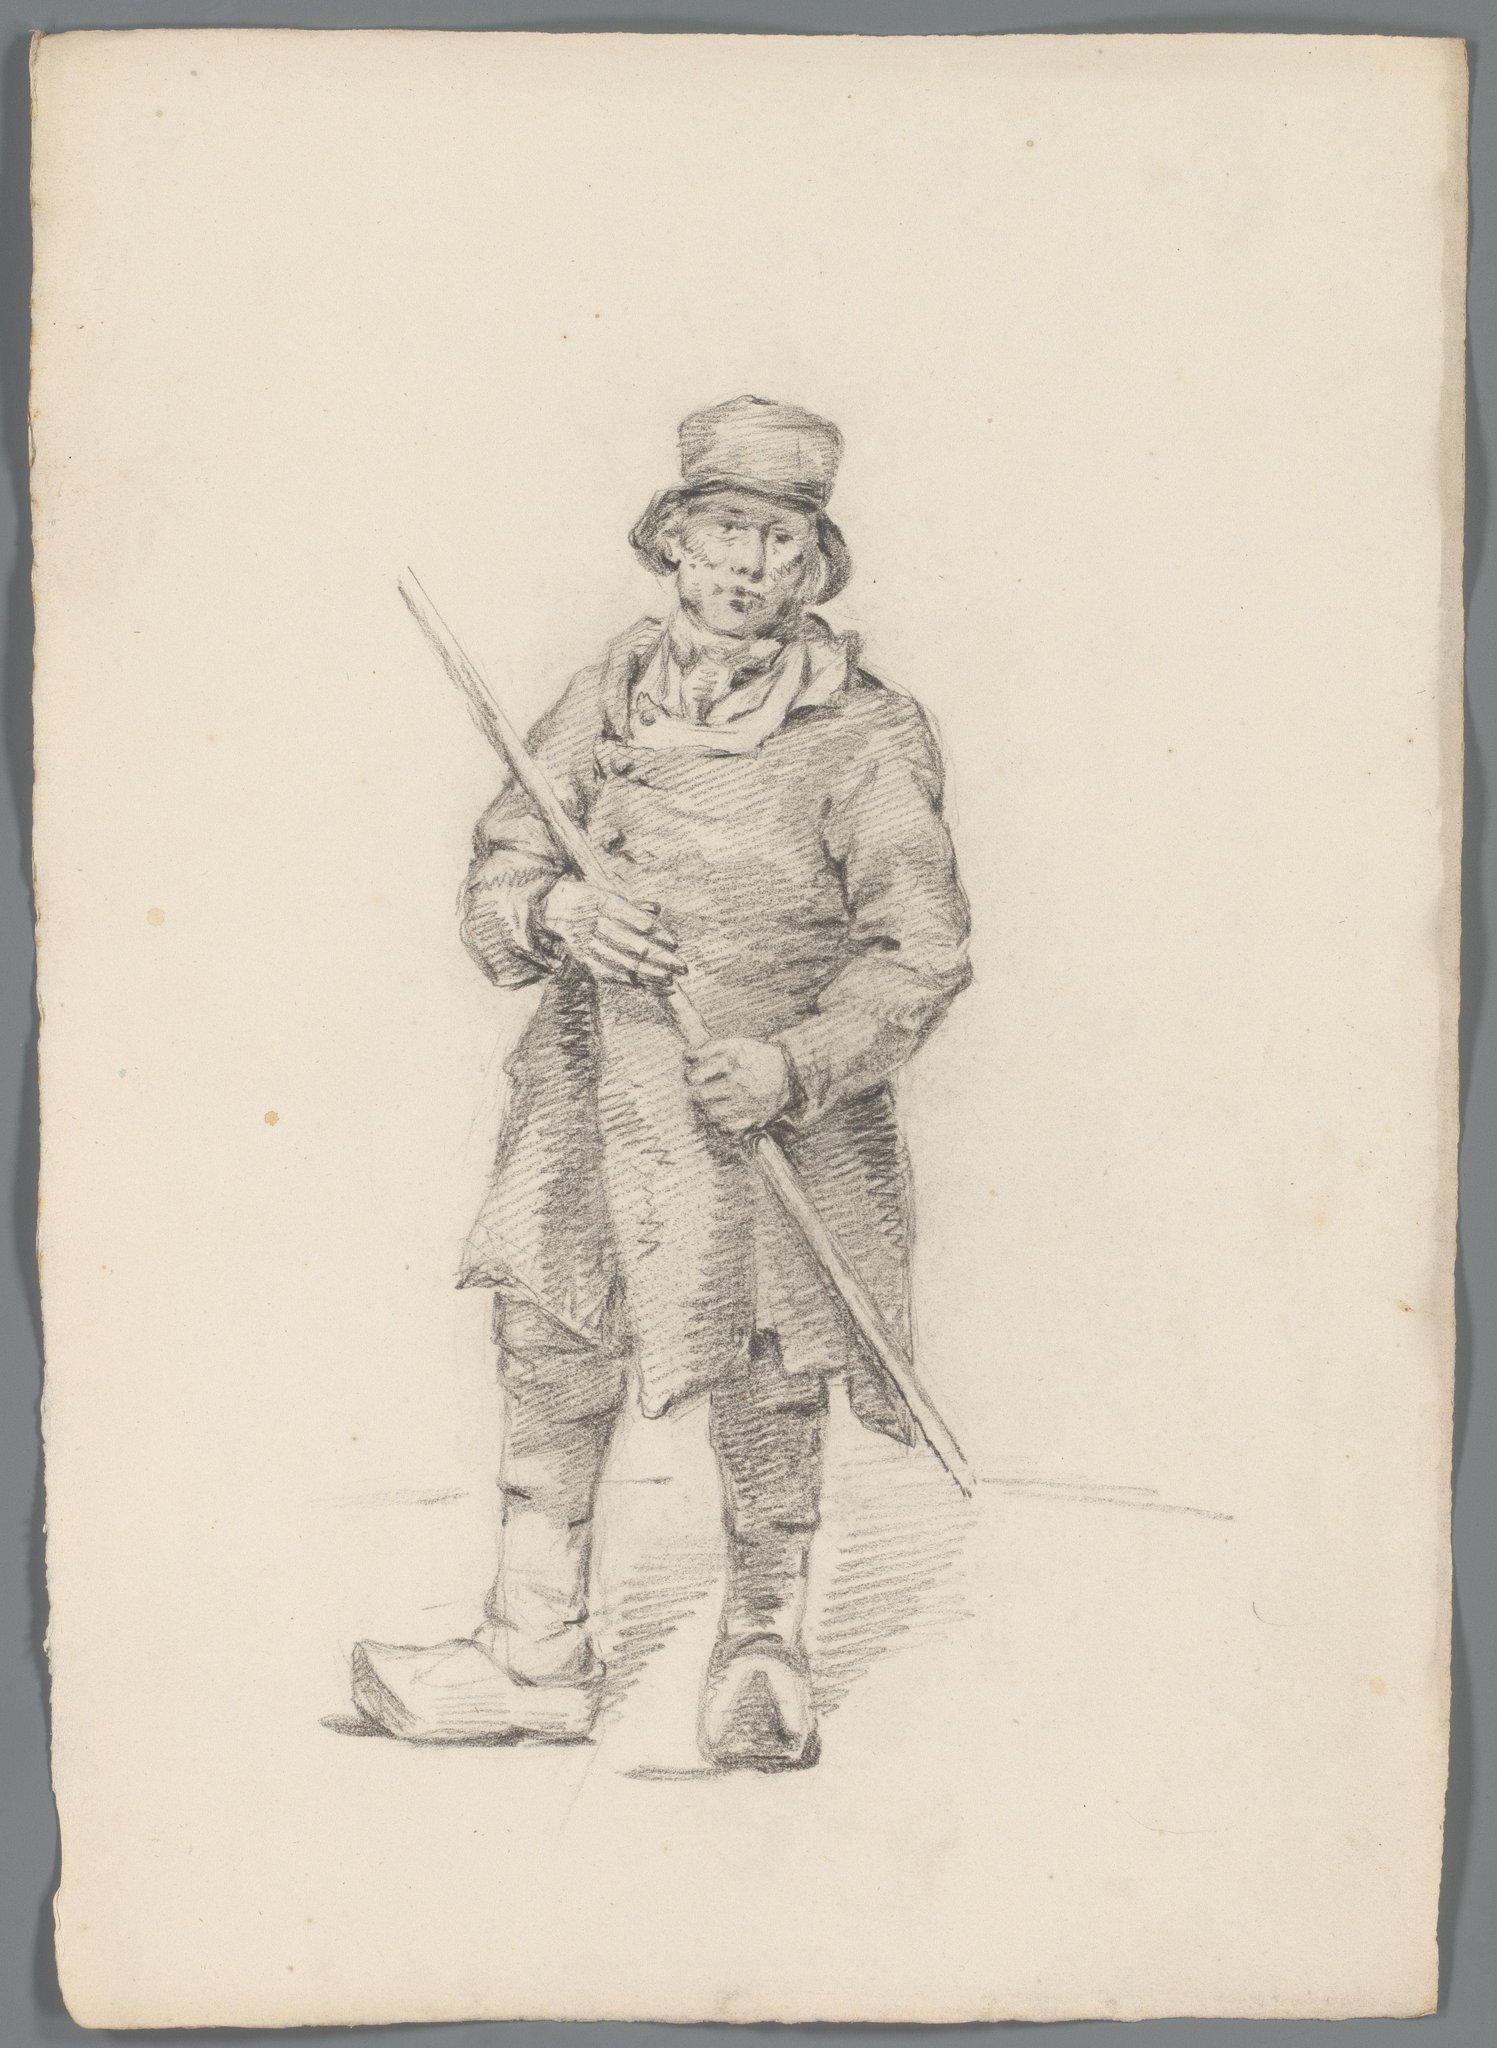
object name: drawing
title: Man met wandelstok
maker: Anonymous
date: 1820-1830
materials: chalk, paper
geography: the hague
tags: walking-stick, staff, wooden shoes, clogs, adult man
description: Tekeningen waarschijnlijk ontstaan bij het Haagse kunstgenootschap ‘Tot Nut der Tekenkunst’, waar twee keer per week tekenavonden werden georganiseerd met geklede modellen.